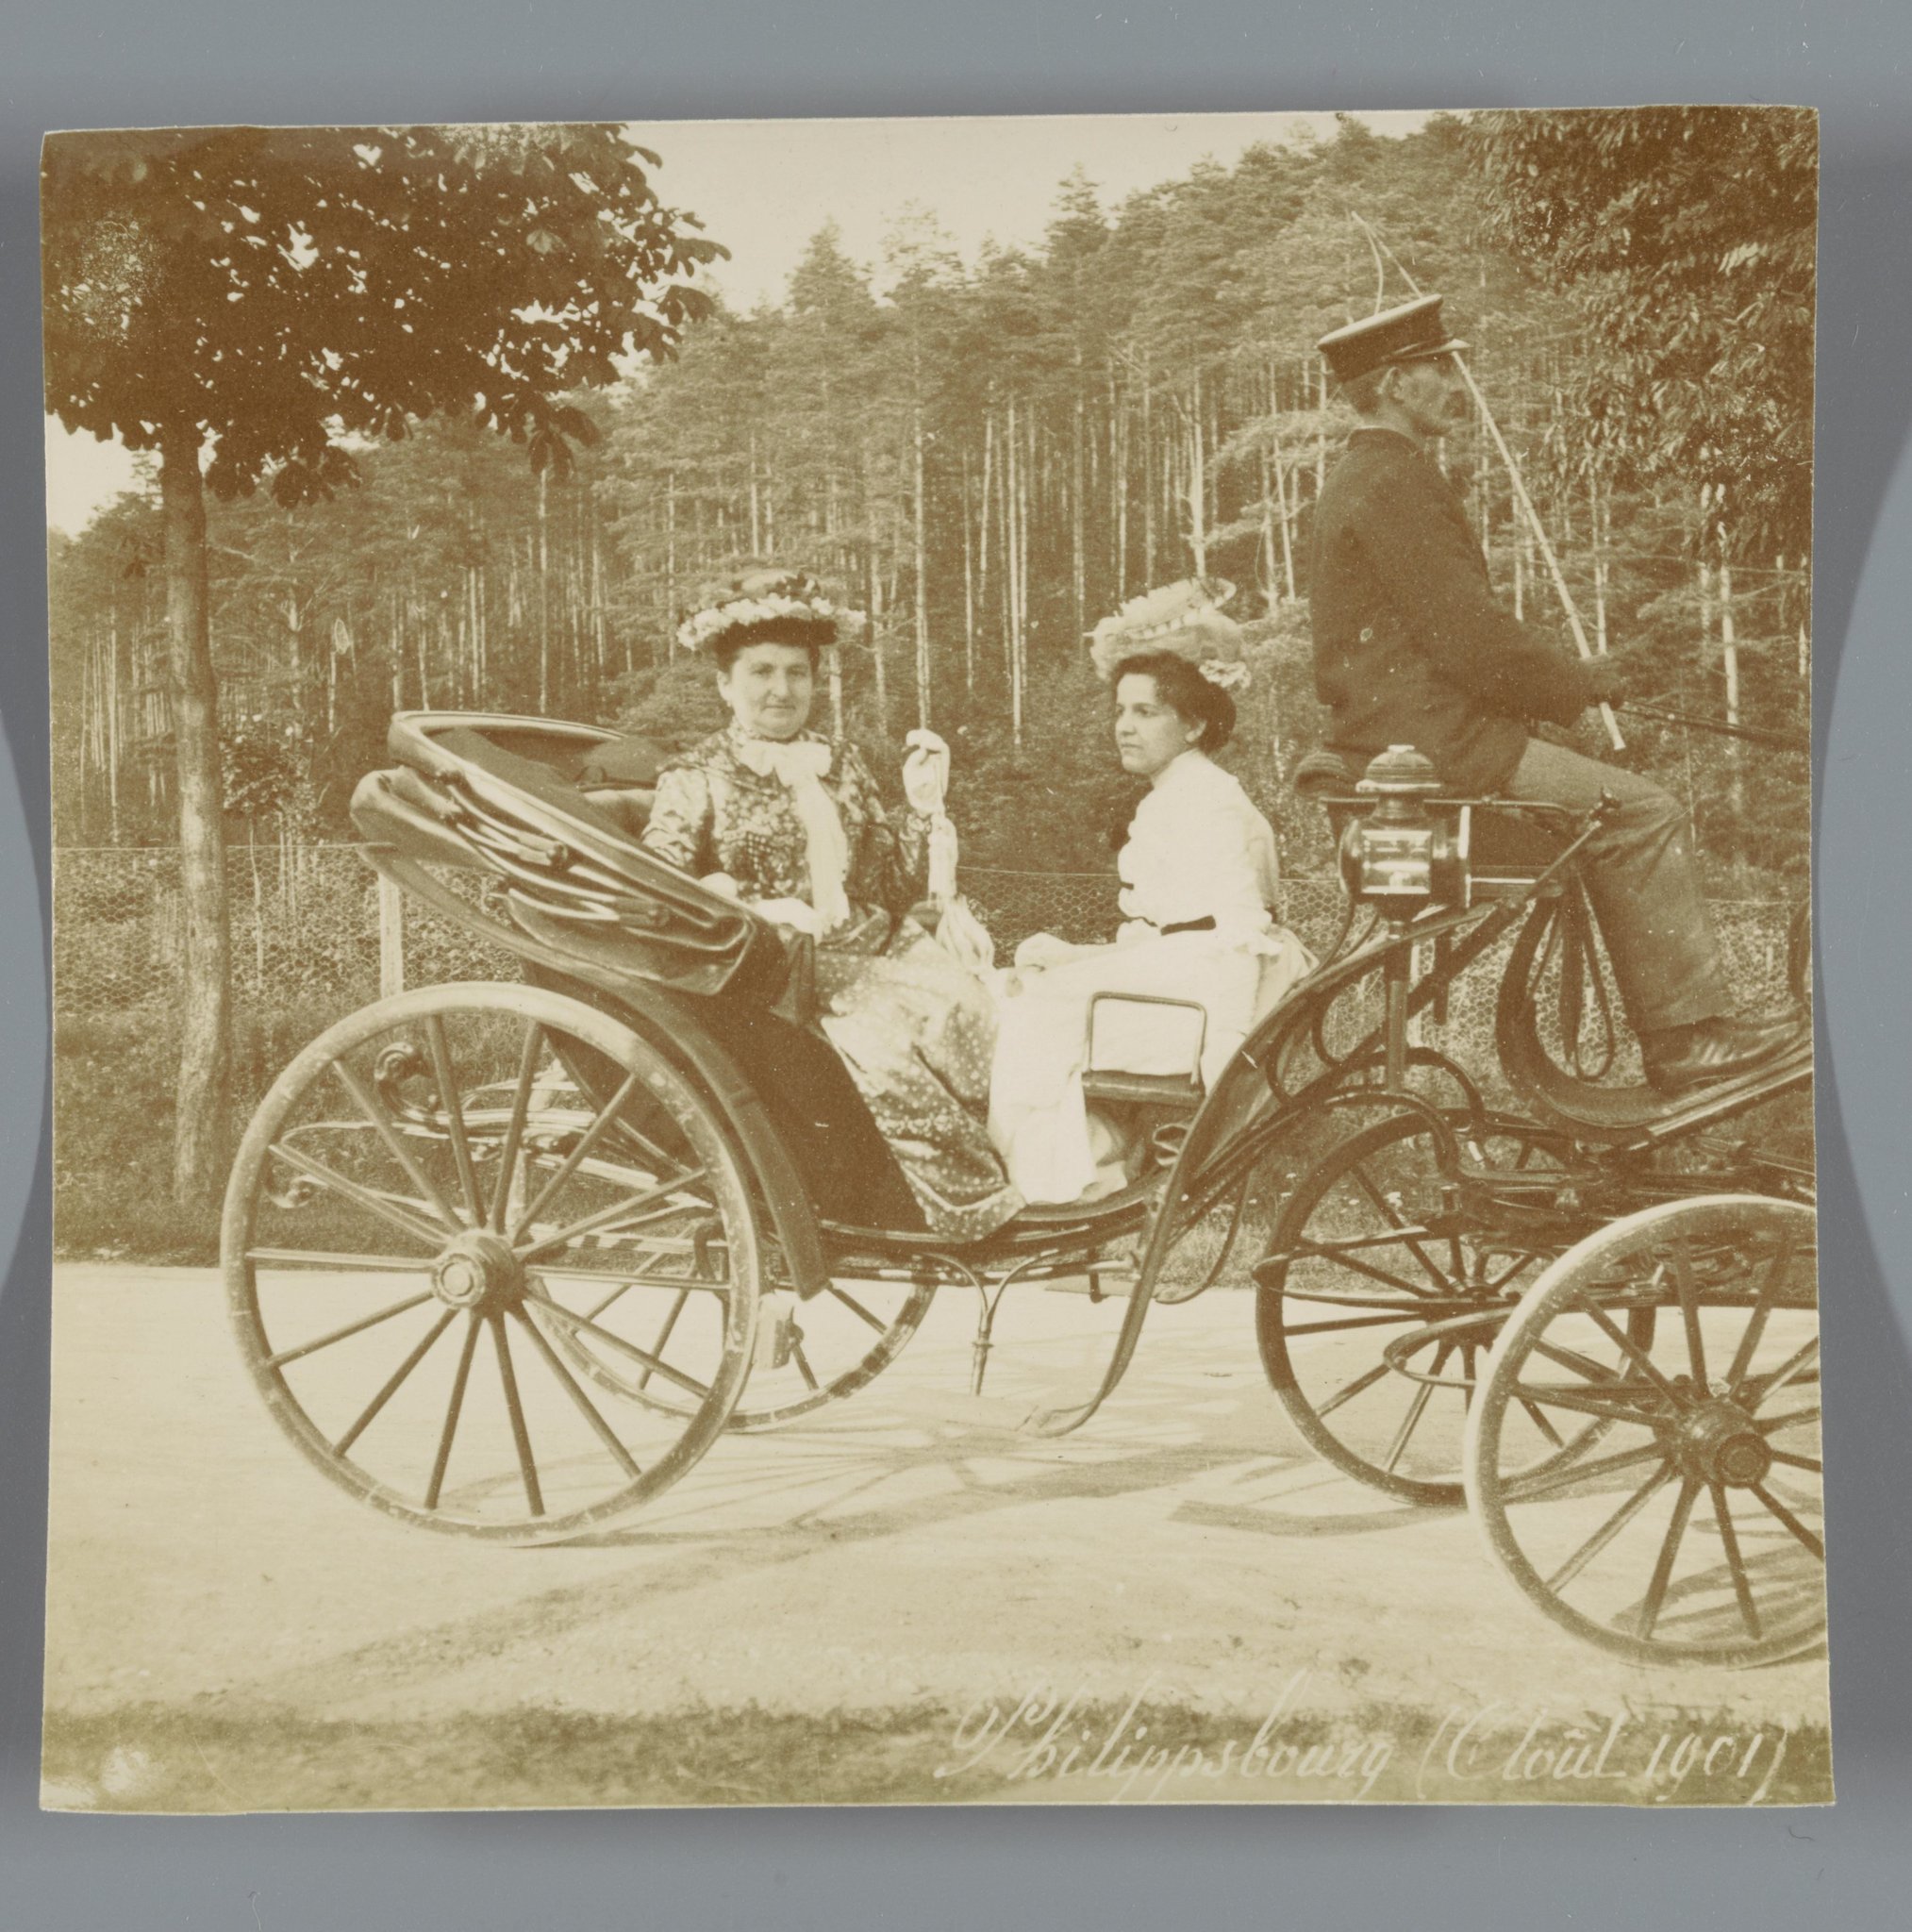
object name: photograph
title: Twee vrouwen in een koets, Philippsbourg (Moselle), Frankrijk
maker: Anonymous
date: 1901-1908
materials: paper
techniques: gelatin silver print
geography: france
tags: four-wheeled, animal-drawn vehicle, e.g.: cab, carriage, coach, france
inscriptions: annotation: ‘Philippsbourg (Août 1901)’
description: Twee vrouwen in een koets, Philippsbourg (Moselle), Frankrijk.